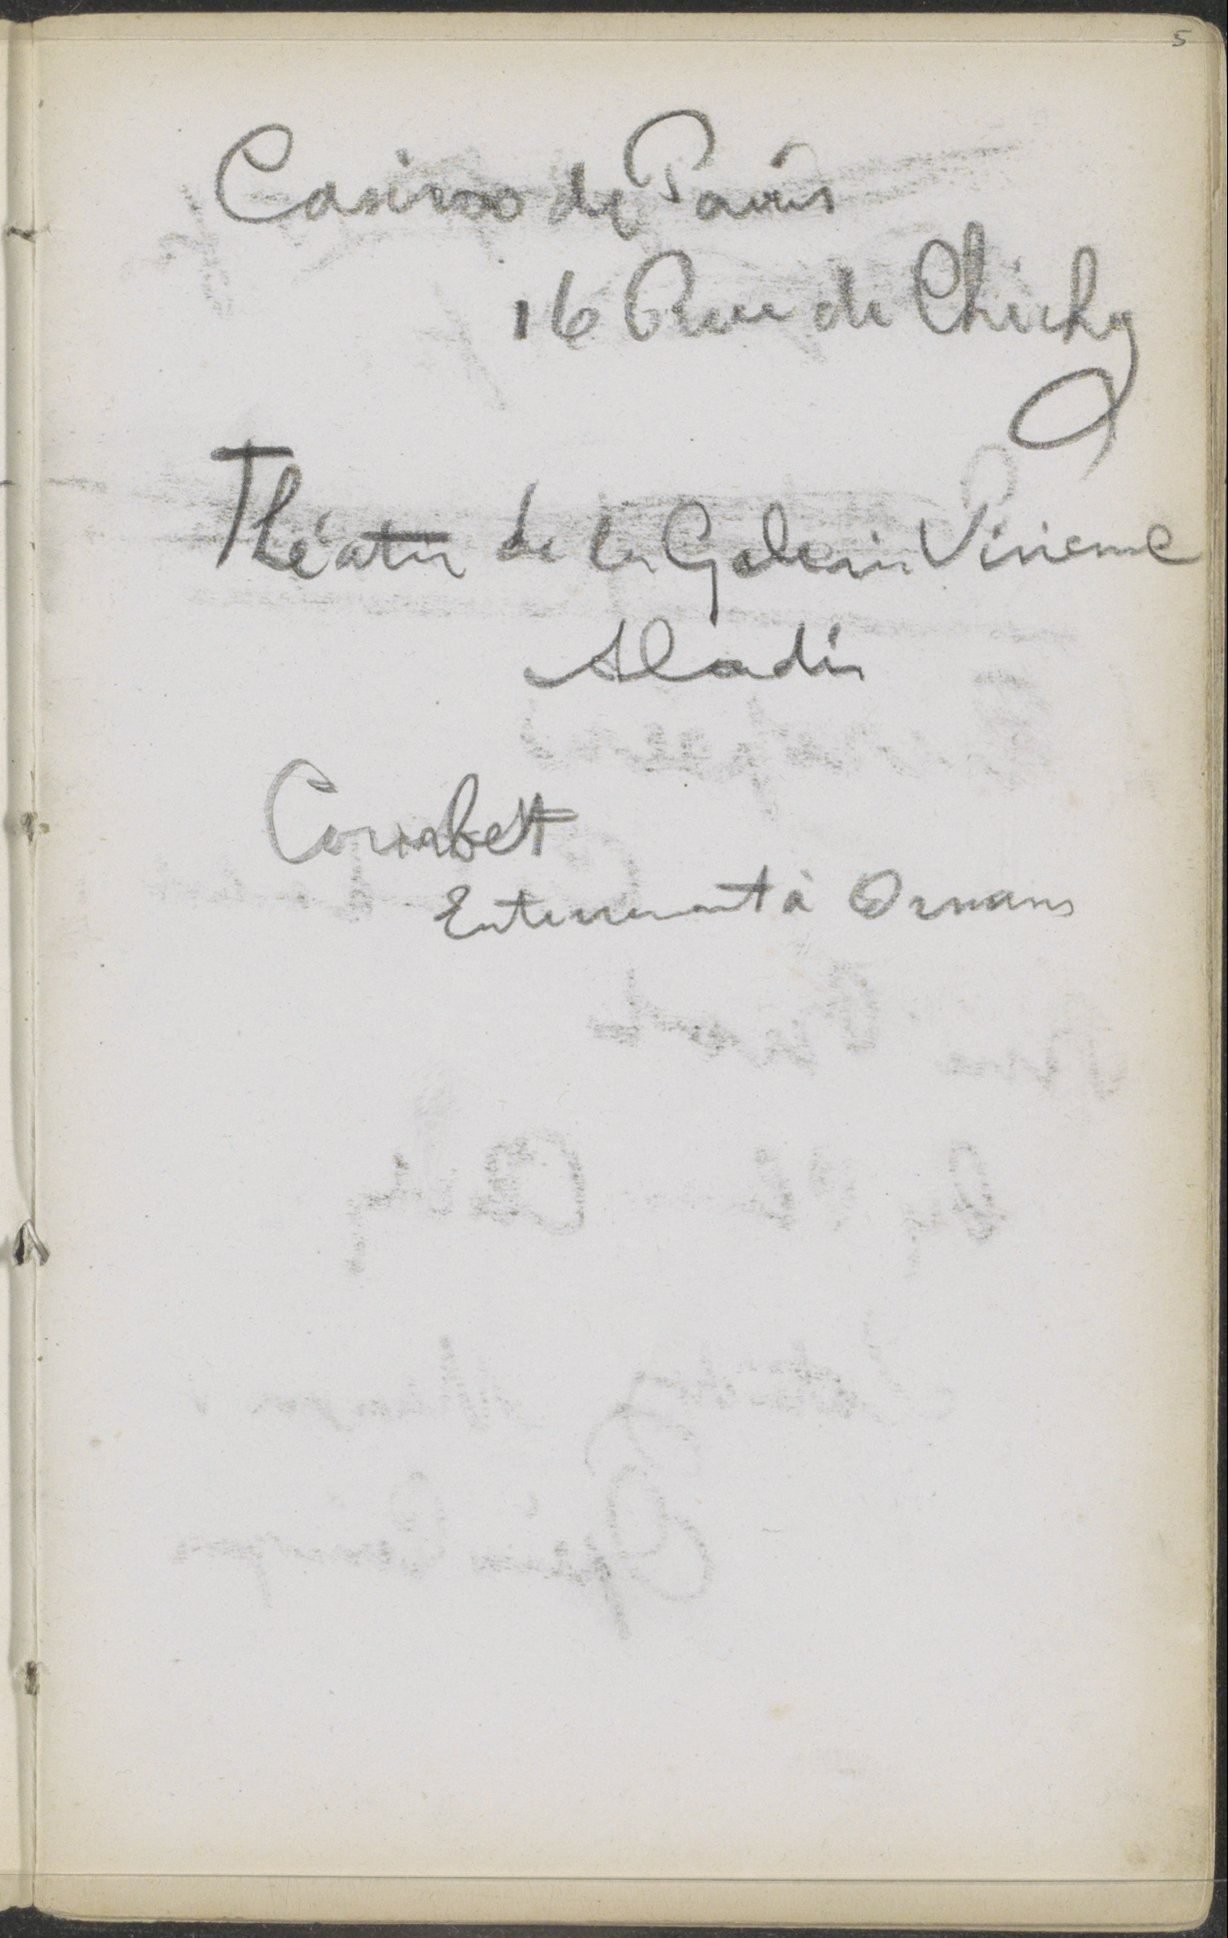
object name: sketchbook leaf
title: Blad met notities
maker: marius bauer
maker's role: draughtsman, print maker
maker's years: 1867-1932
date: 1810-1891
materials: chalk, paper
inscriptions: annotation: ‘Casino de Paris/ 16 Rue de Clichy/ Theatre de la Galaine Vincenne/ Aladin/ Courbet/ Enterrement à Ornans’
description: Pagina 5 uit een schetsboek met 35 bladen.